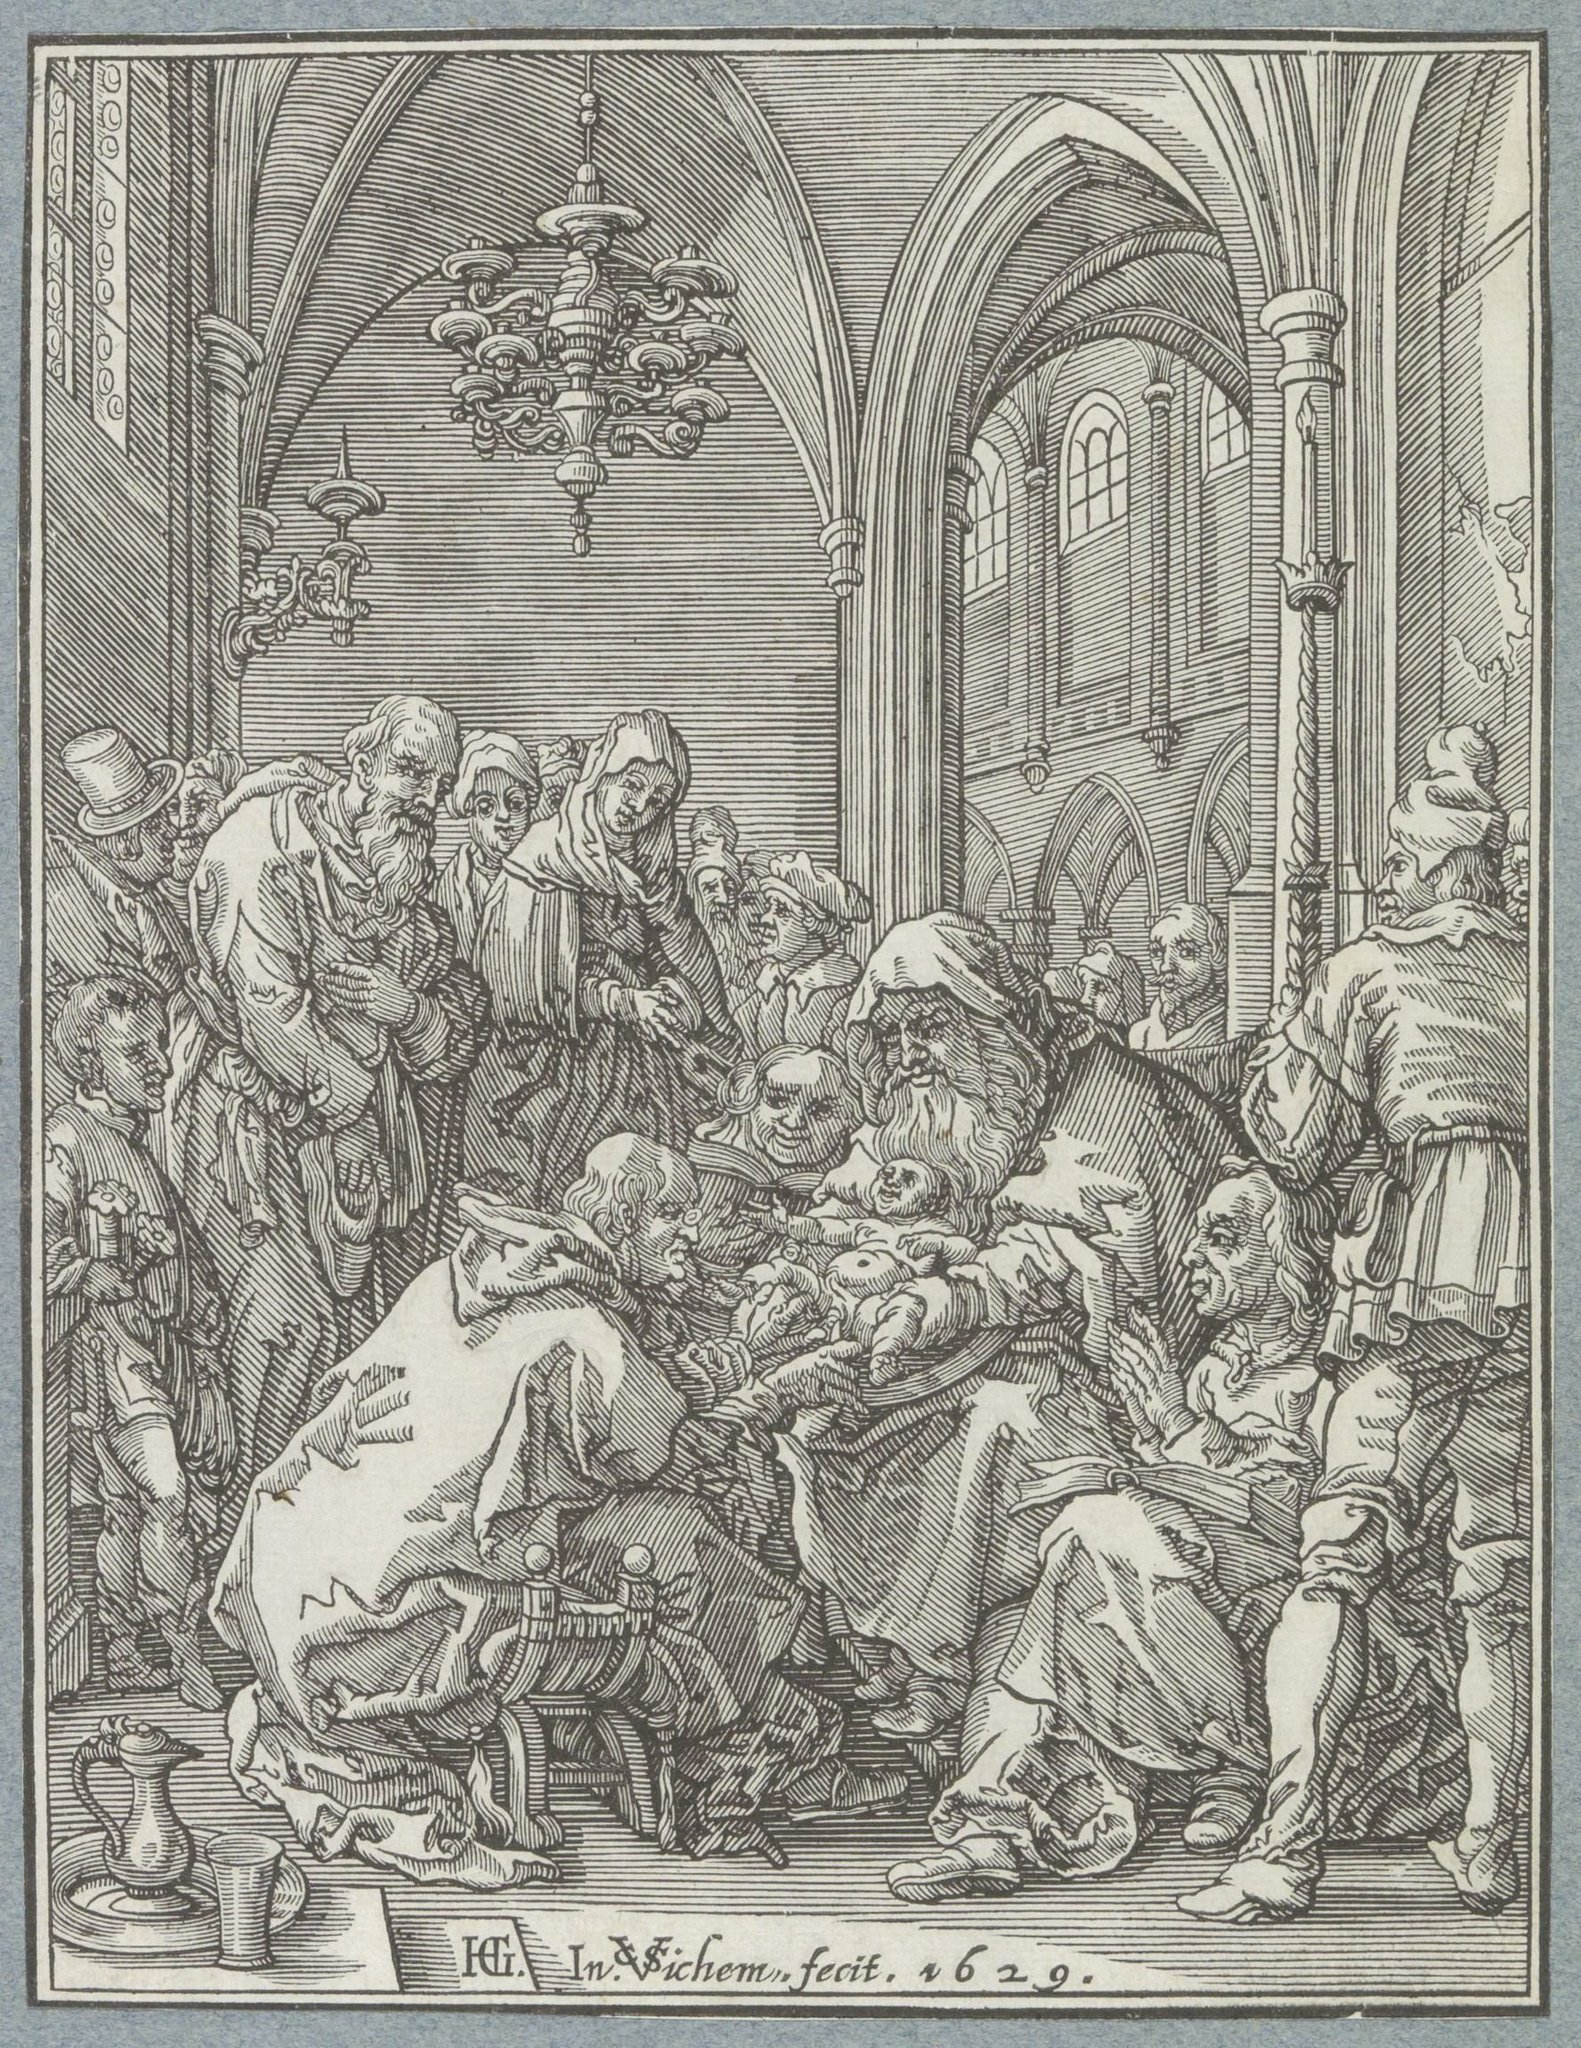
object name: album leaf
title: Besnijdenis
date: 1629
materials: paper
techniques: woodcut, pasting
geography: amsterdam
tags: circumcision of the christ-child by the priest in the temple (luke 2:21)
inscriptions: date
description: Het Christuskind wordt besneden in een kapel in een grote kerk. Veel omstanders kijken toe. De prent maakt deel uit van een album.